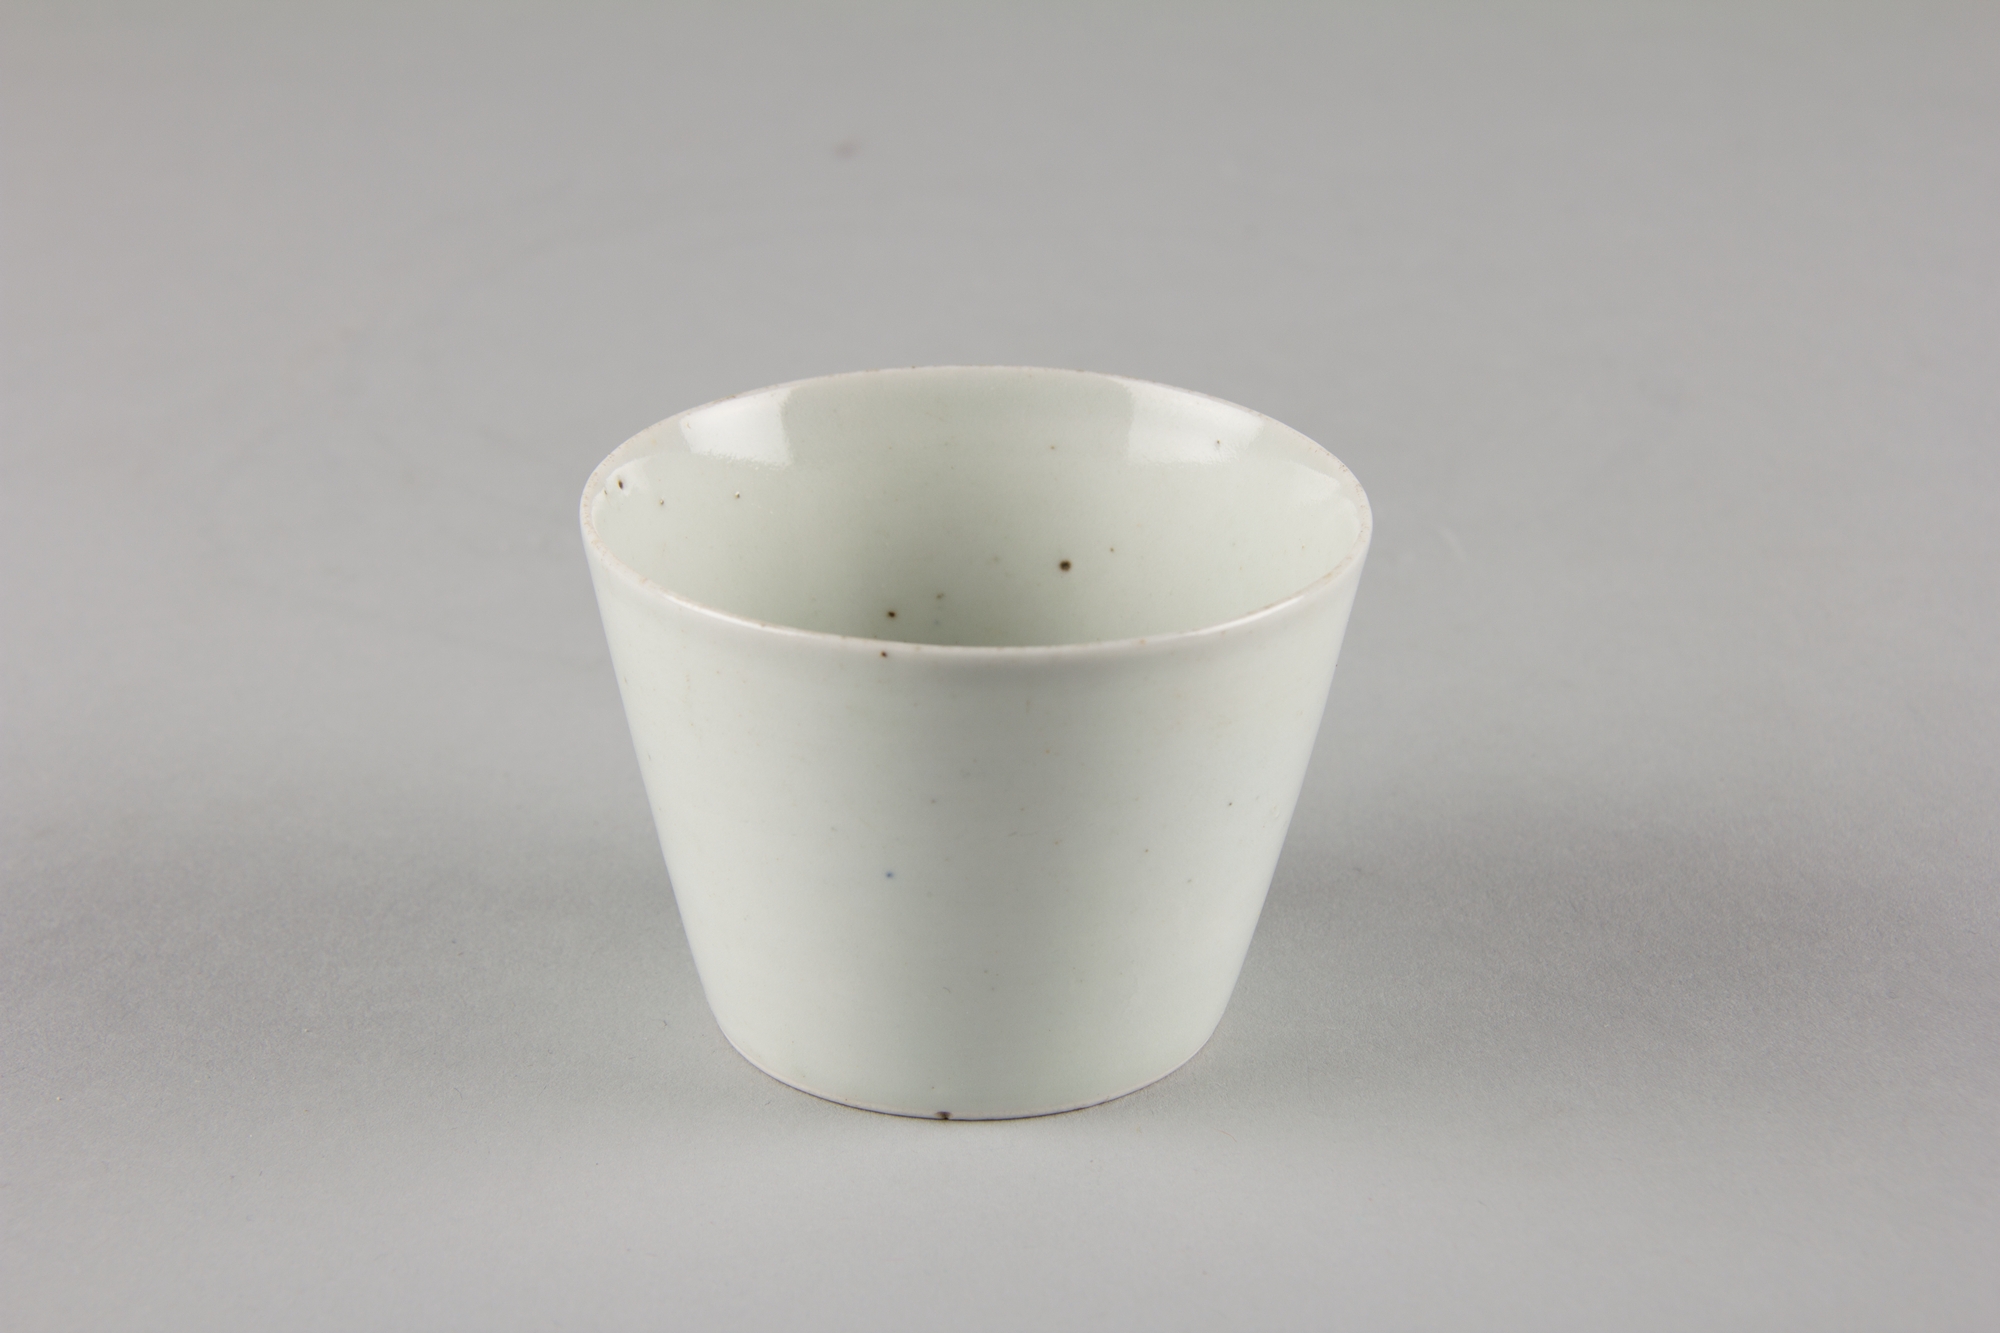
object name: soba cup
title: One from a Set of Five Soba Cups with Chrysanthemum Design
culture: japanese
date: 1615-1868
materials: porcelain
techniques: underglaze